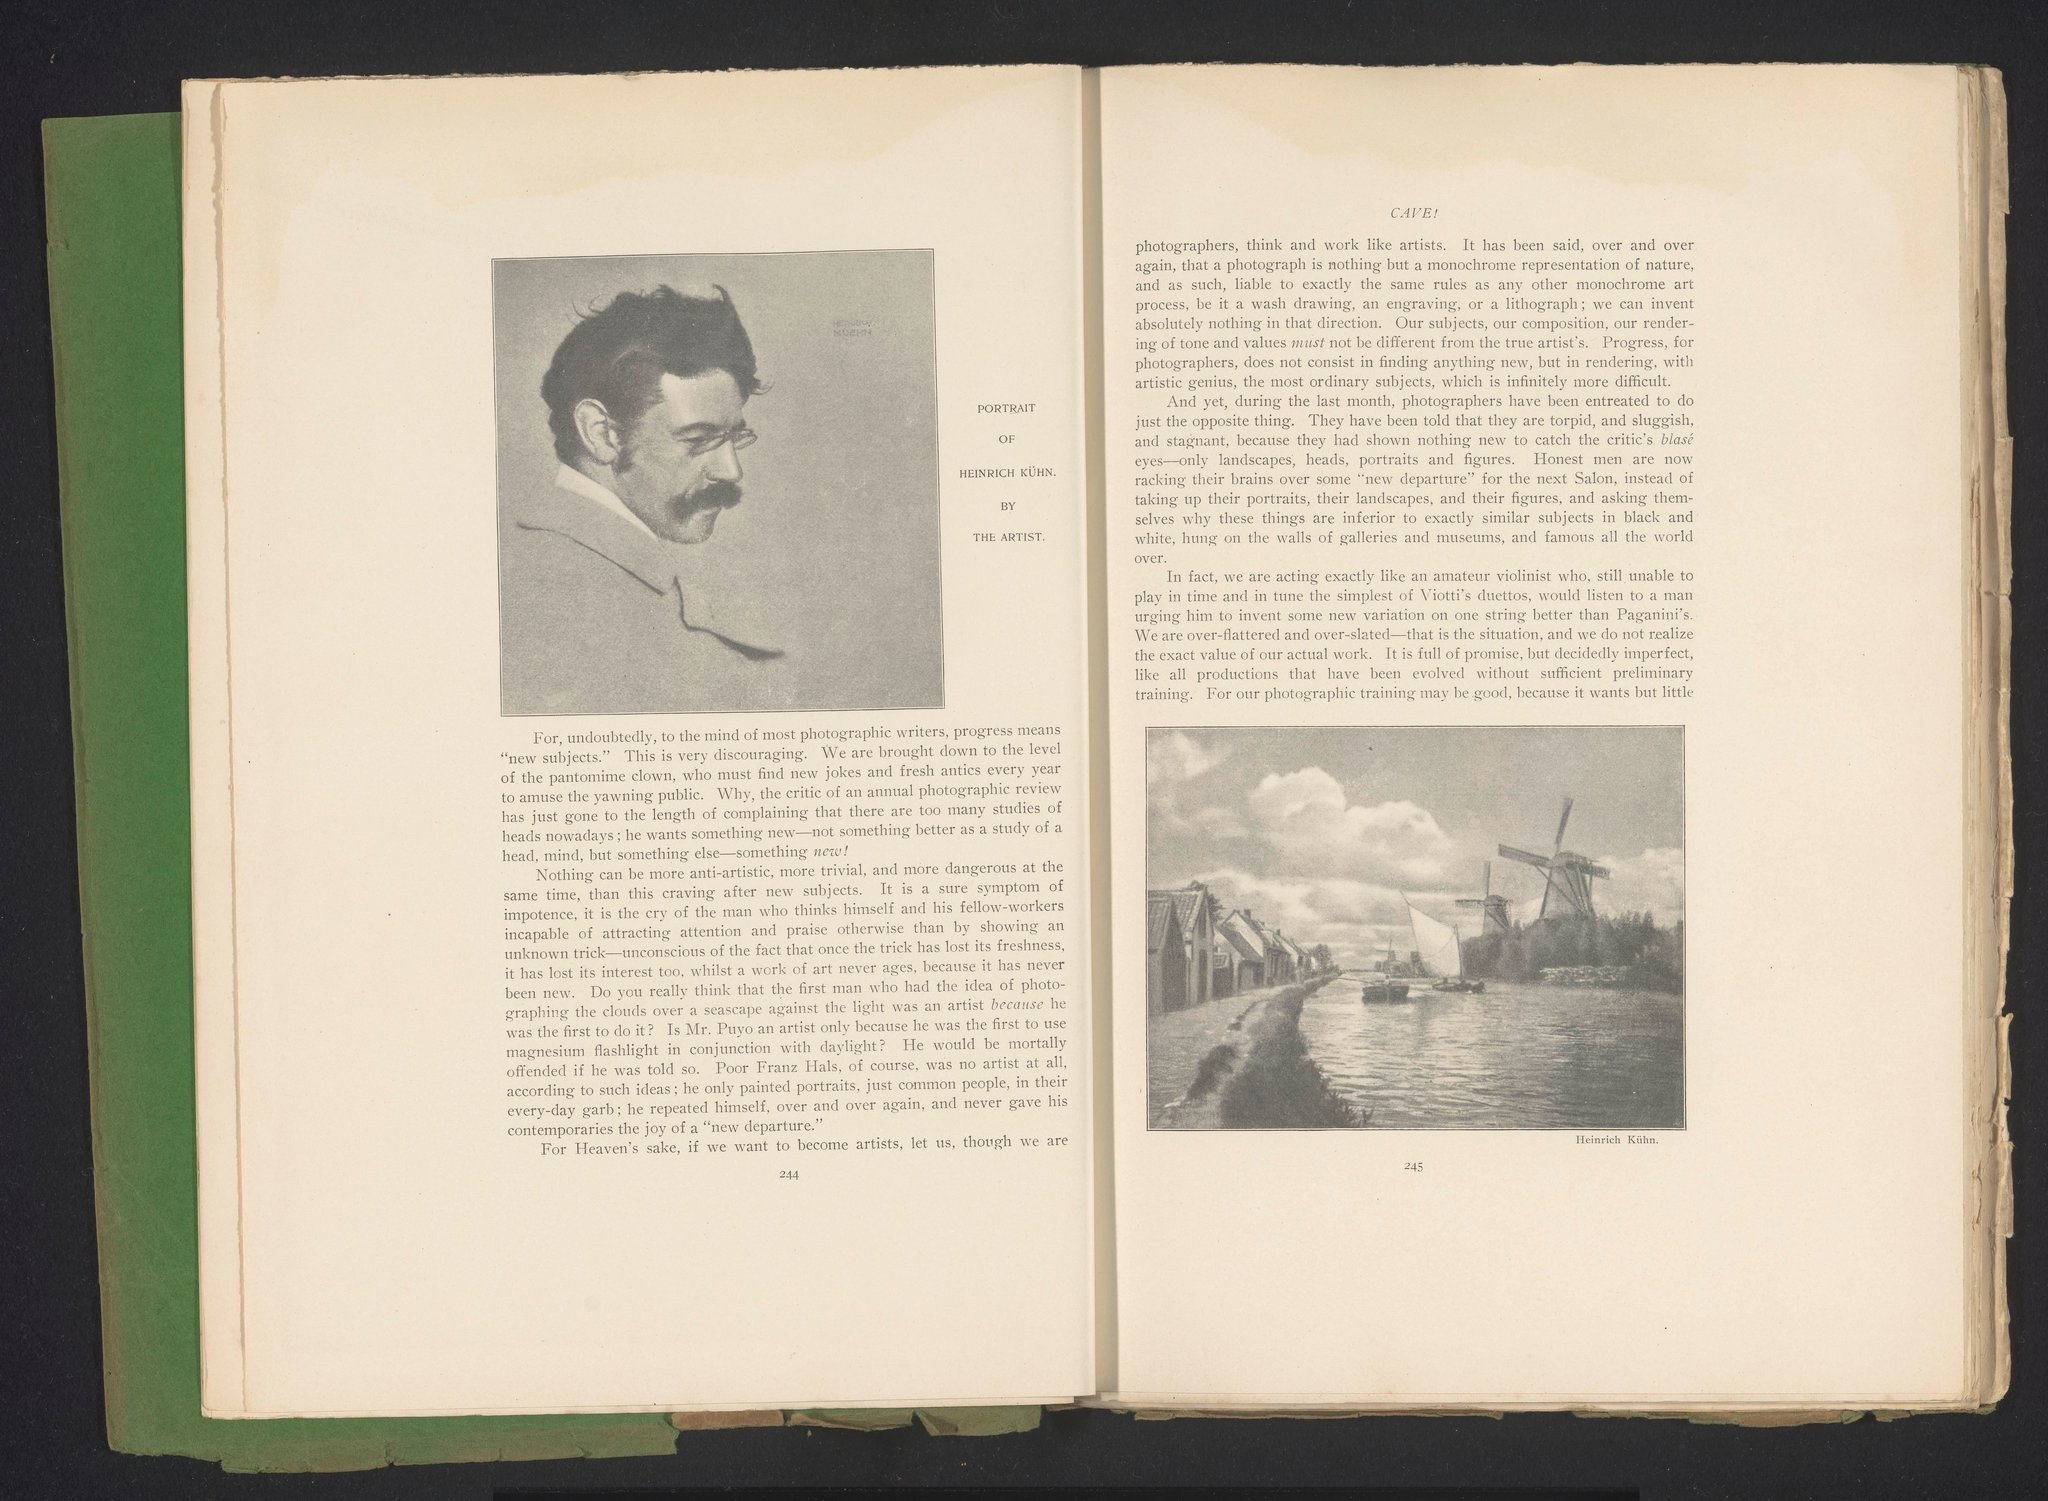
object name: page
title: Gezicht op een waterweg met zeilboten, met op de oever twee molens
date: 1897-1902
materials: paper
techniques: autotype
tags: sailing-ship, sailing-boat, river, windmill